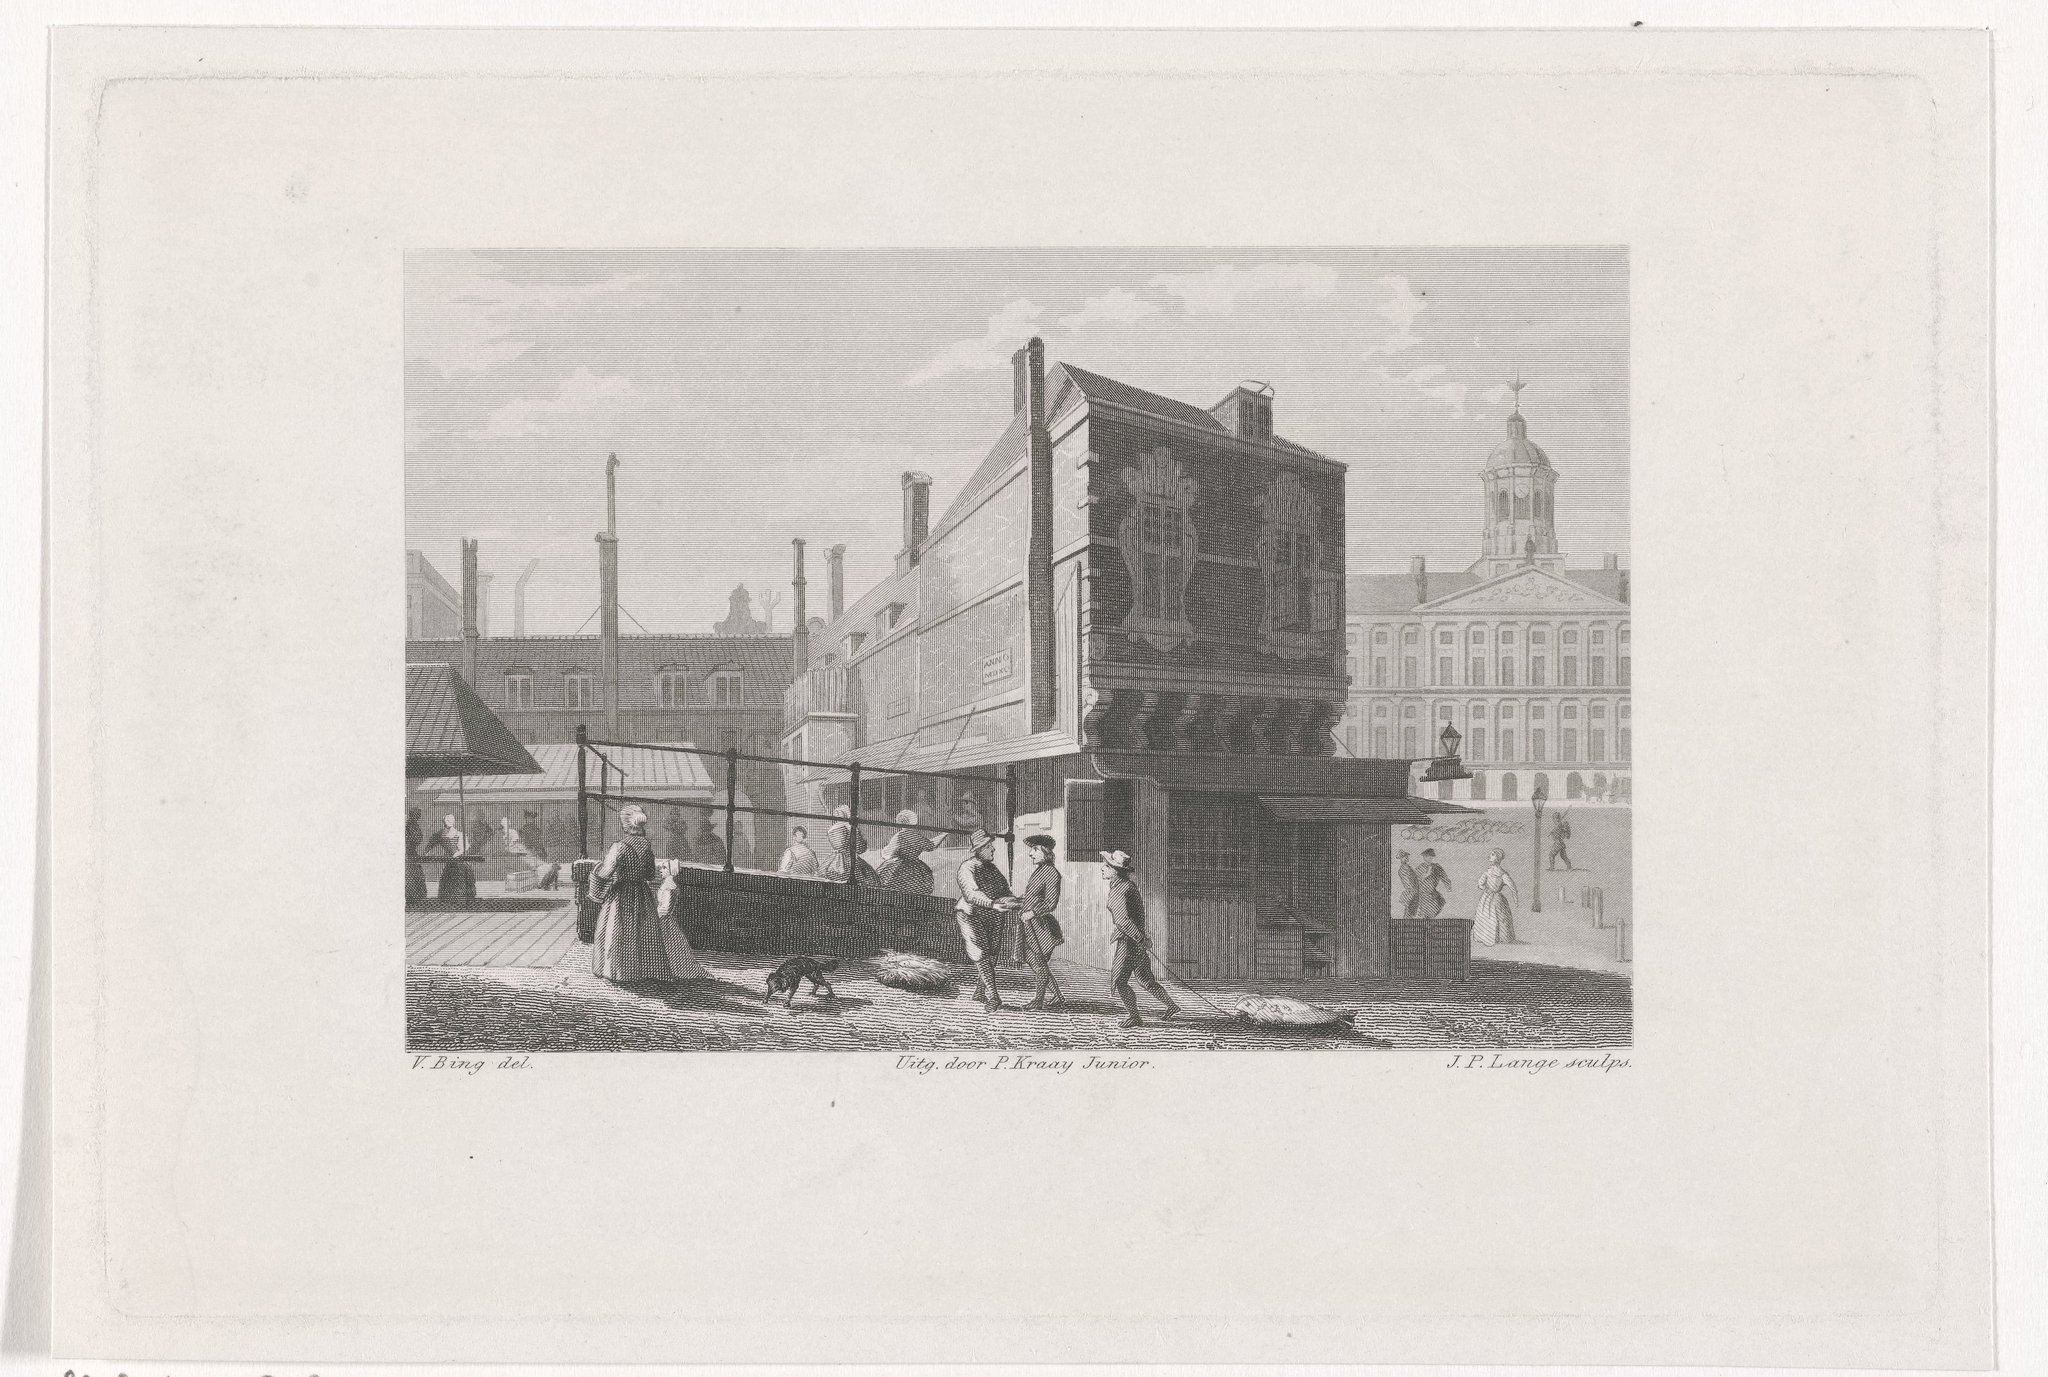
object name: print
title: Gezicht op de Vismarkt te Amsterdam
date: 1822-1849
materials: paper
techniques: engraving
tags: royal palace of amsterdam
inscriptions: collector's mark: Lugt 2228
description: Gezicht op de Vismarkt te Amsterdam, rechts ligt het Paleis op de Dam.